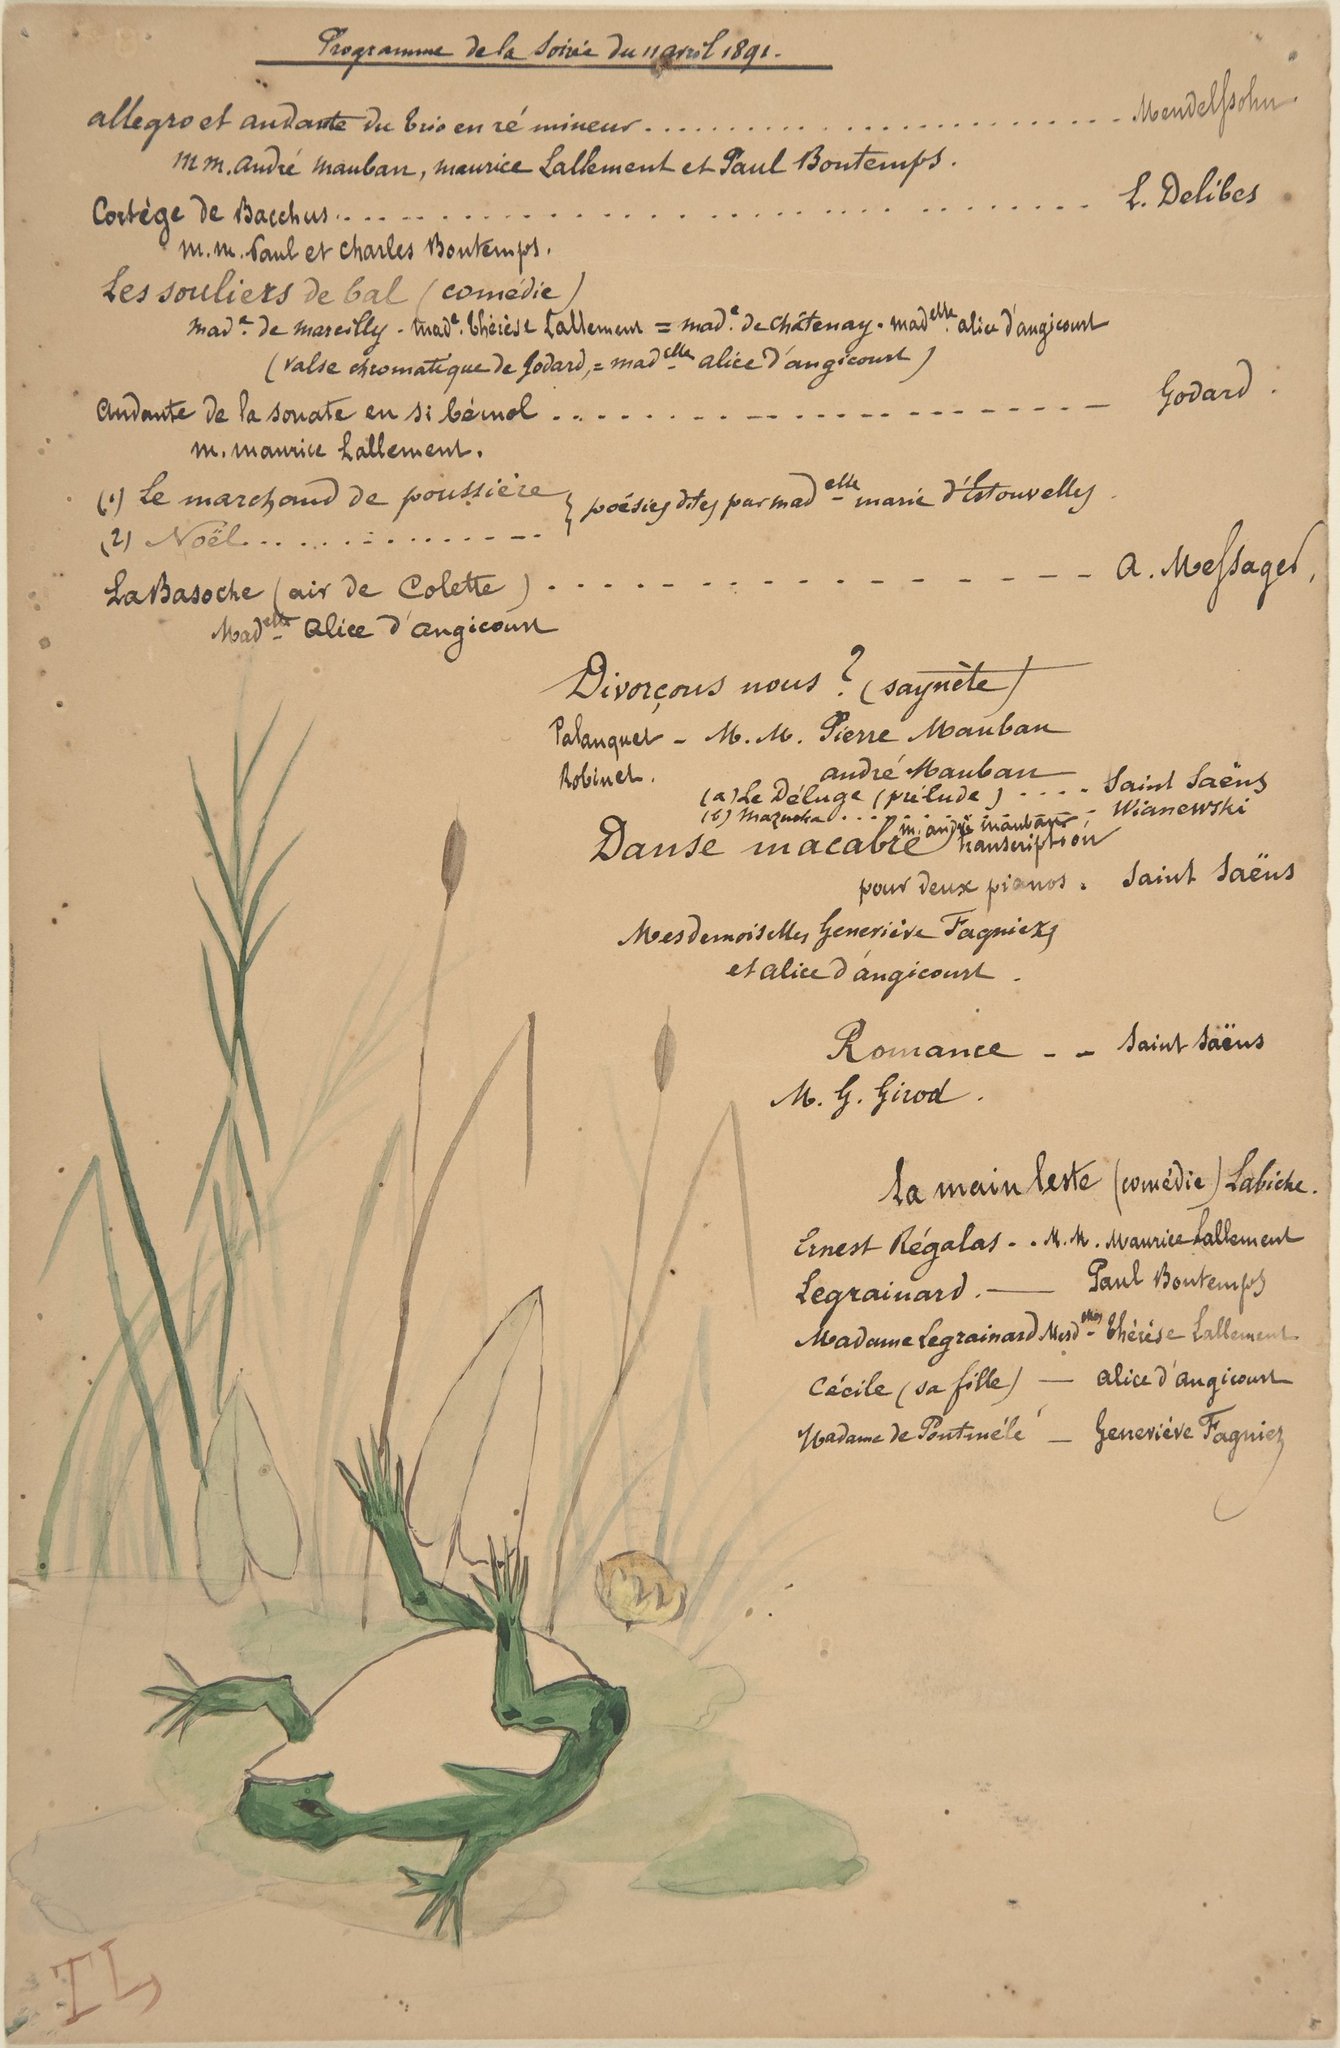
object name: drawing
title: Program for the Evening of April 11, 1891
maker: anonymous, french, 19th century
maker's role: artist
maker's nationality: french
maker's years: 1800-1900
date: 1891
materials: ink, watercolor, paper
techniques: pen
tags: frogs,leaves